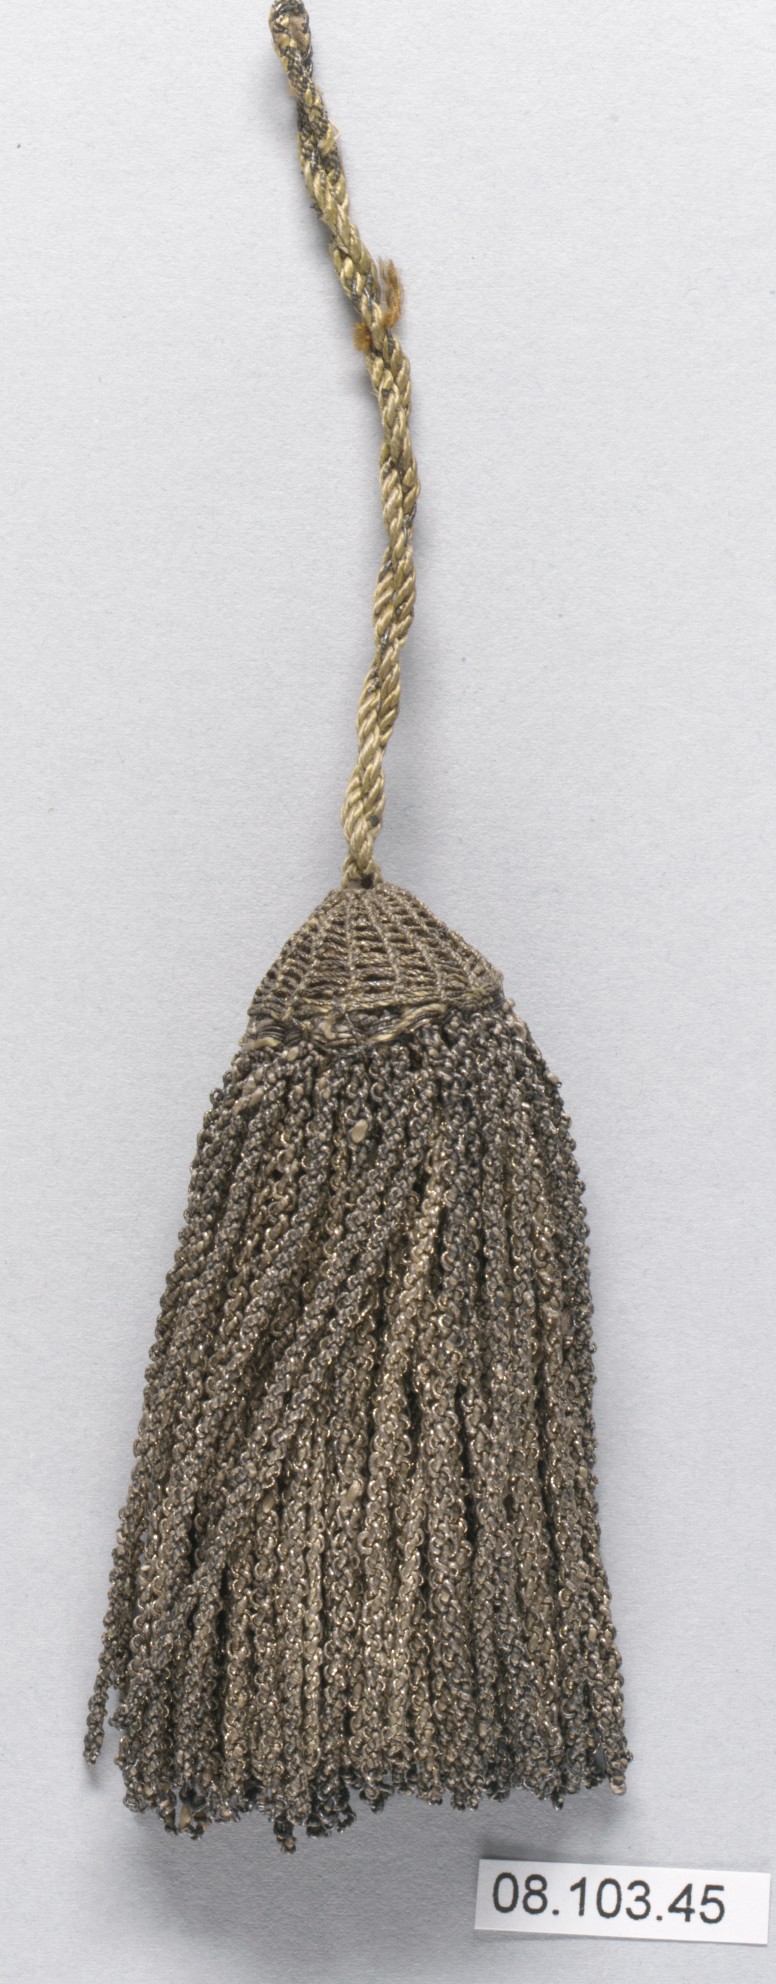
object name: tassel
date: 1701-1800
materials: metal thread